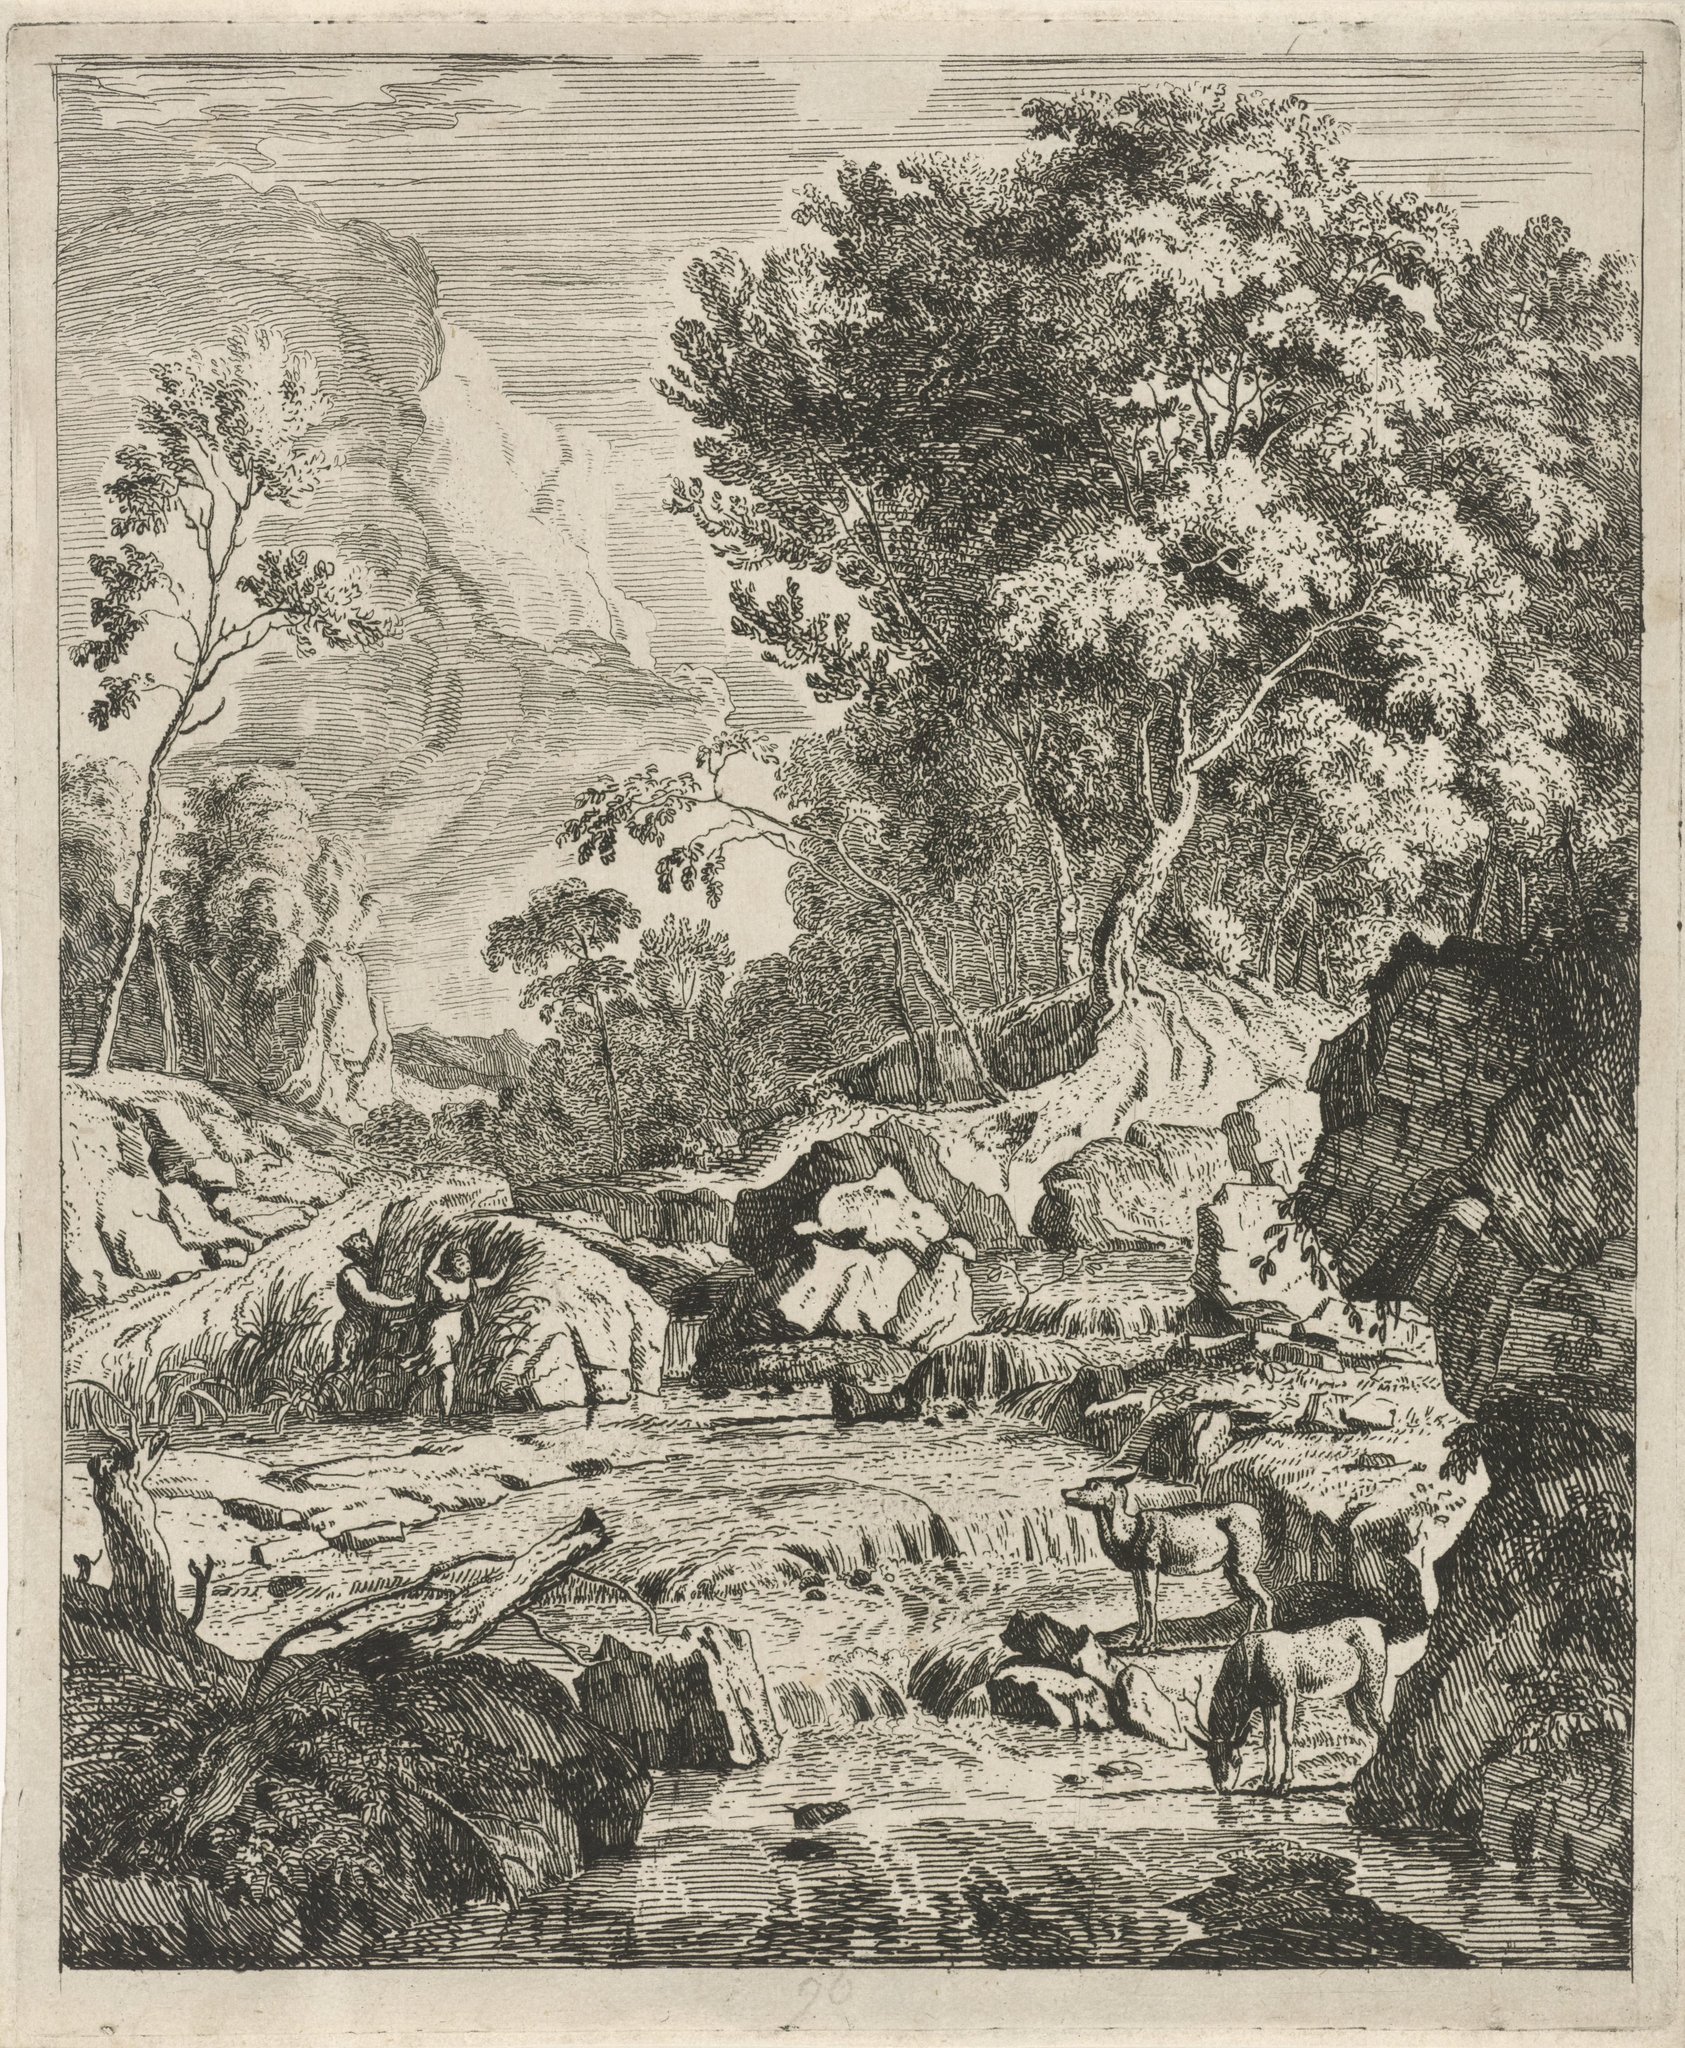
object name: print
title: Pan en Syrinx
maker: albert meyering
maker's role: draughtsman, print maker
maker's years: 1645-1714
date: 1695-1714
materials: paper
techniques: etching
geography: amsterdam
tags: hoofed animals: deer, river, syrinx changed into a reed: while fleeing from pan, the nymph syrinx is changed into reed by her sisters, the naiads (ovid, metamorphoses i 705)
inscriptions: collector's mark: Lugt 2228, collector's mark: Lugt 3530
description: Langs de waterkant achtervolgt Pan de nimf Syrinx, die in een bos riet verandert. Op de voorgrond de rivier, daarbij twee herten.